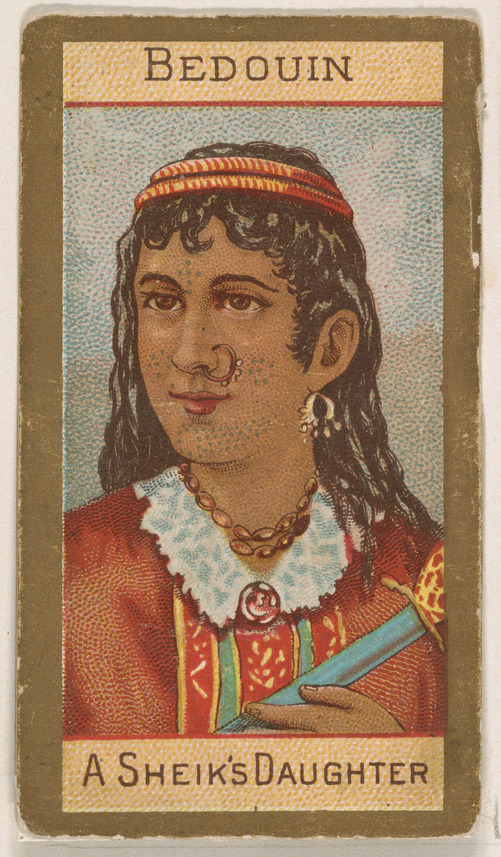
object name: print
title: Bedouin, A Sheik's Daughter, from Types of Nationalities (N240) issued by Kinney Bros.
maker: kinney brothers tobacco company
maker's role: publisher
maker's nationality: american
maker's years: 1869-2011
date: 1890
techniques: color lithograph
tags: women